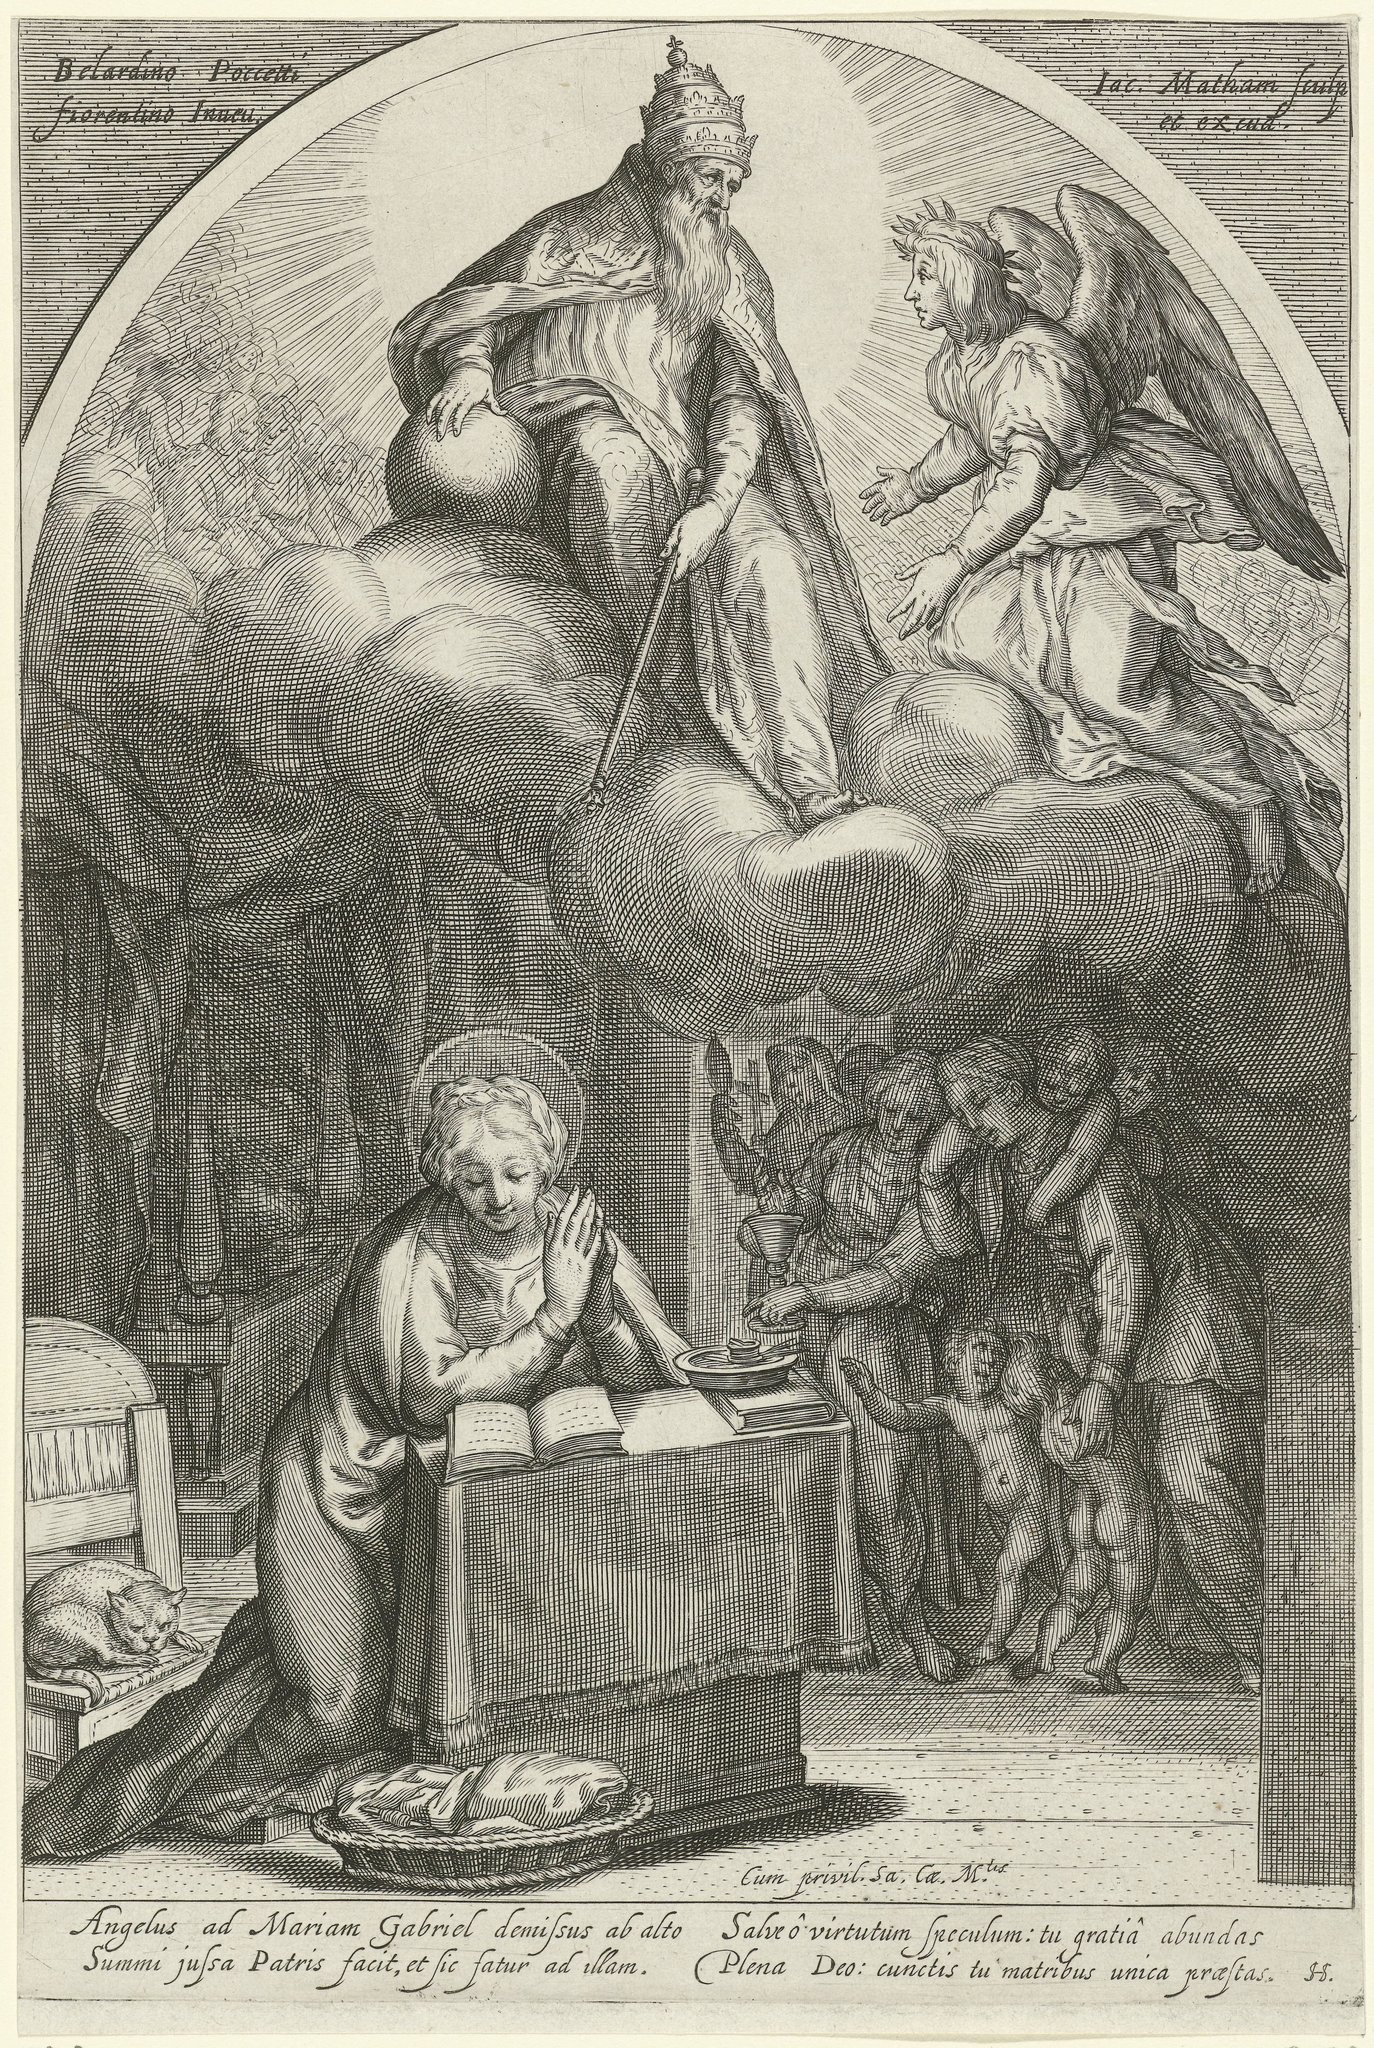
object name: print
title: Annunciatie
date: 1601-1605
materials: paper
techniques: engraving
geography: haarlem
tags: sending of gabriel ~ 'ratschluss der erlösung', the announcement of christ's birth (luke 1:26-38)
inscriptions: collector's mark: Lugt 2228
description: God de Vader en de aartsengel Gabriël met elkaar in gesprek. God de Vader wijst met zijn scepter naar beneden waar Maria geknield op een bidstoel in gebed is.